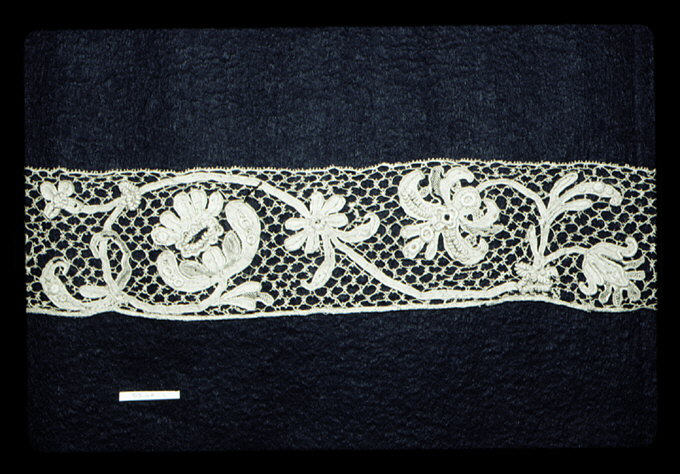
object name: band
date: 1701-1800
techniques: lace